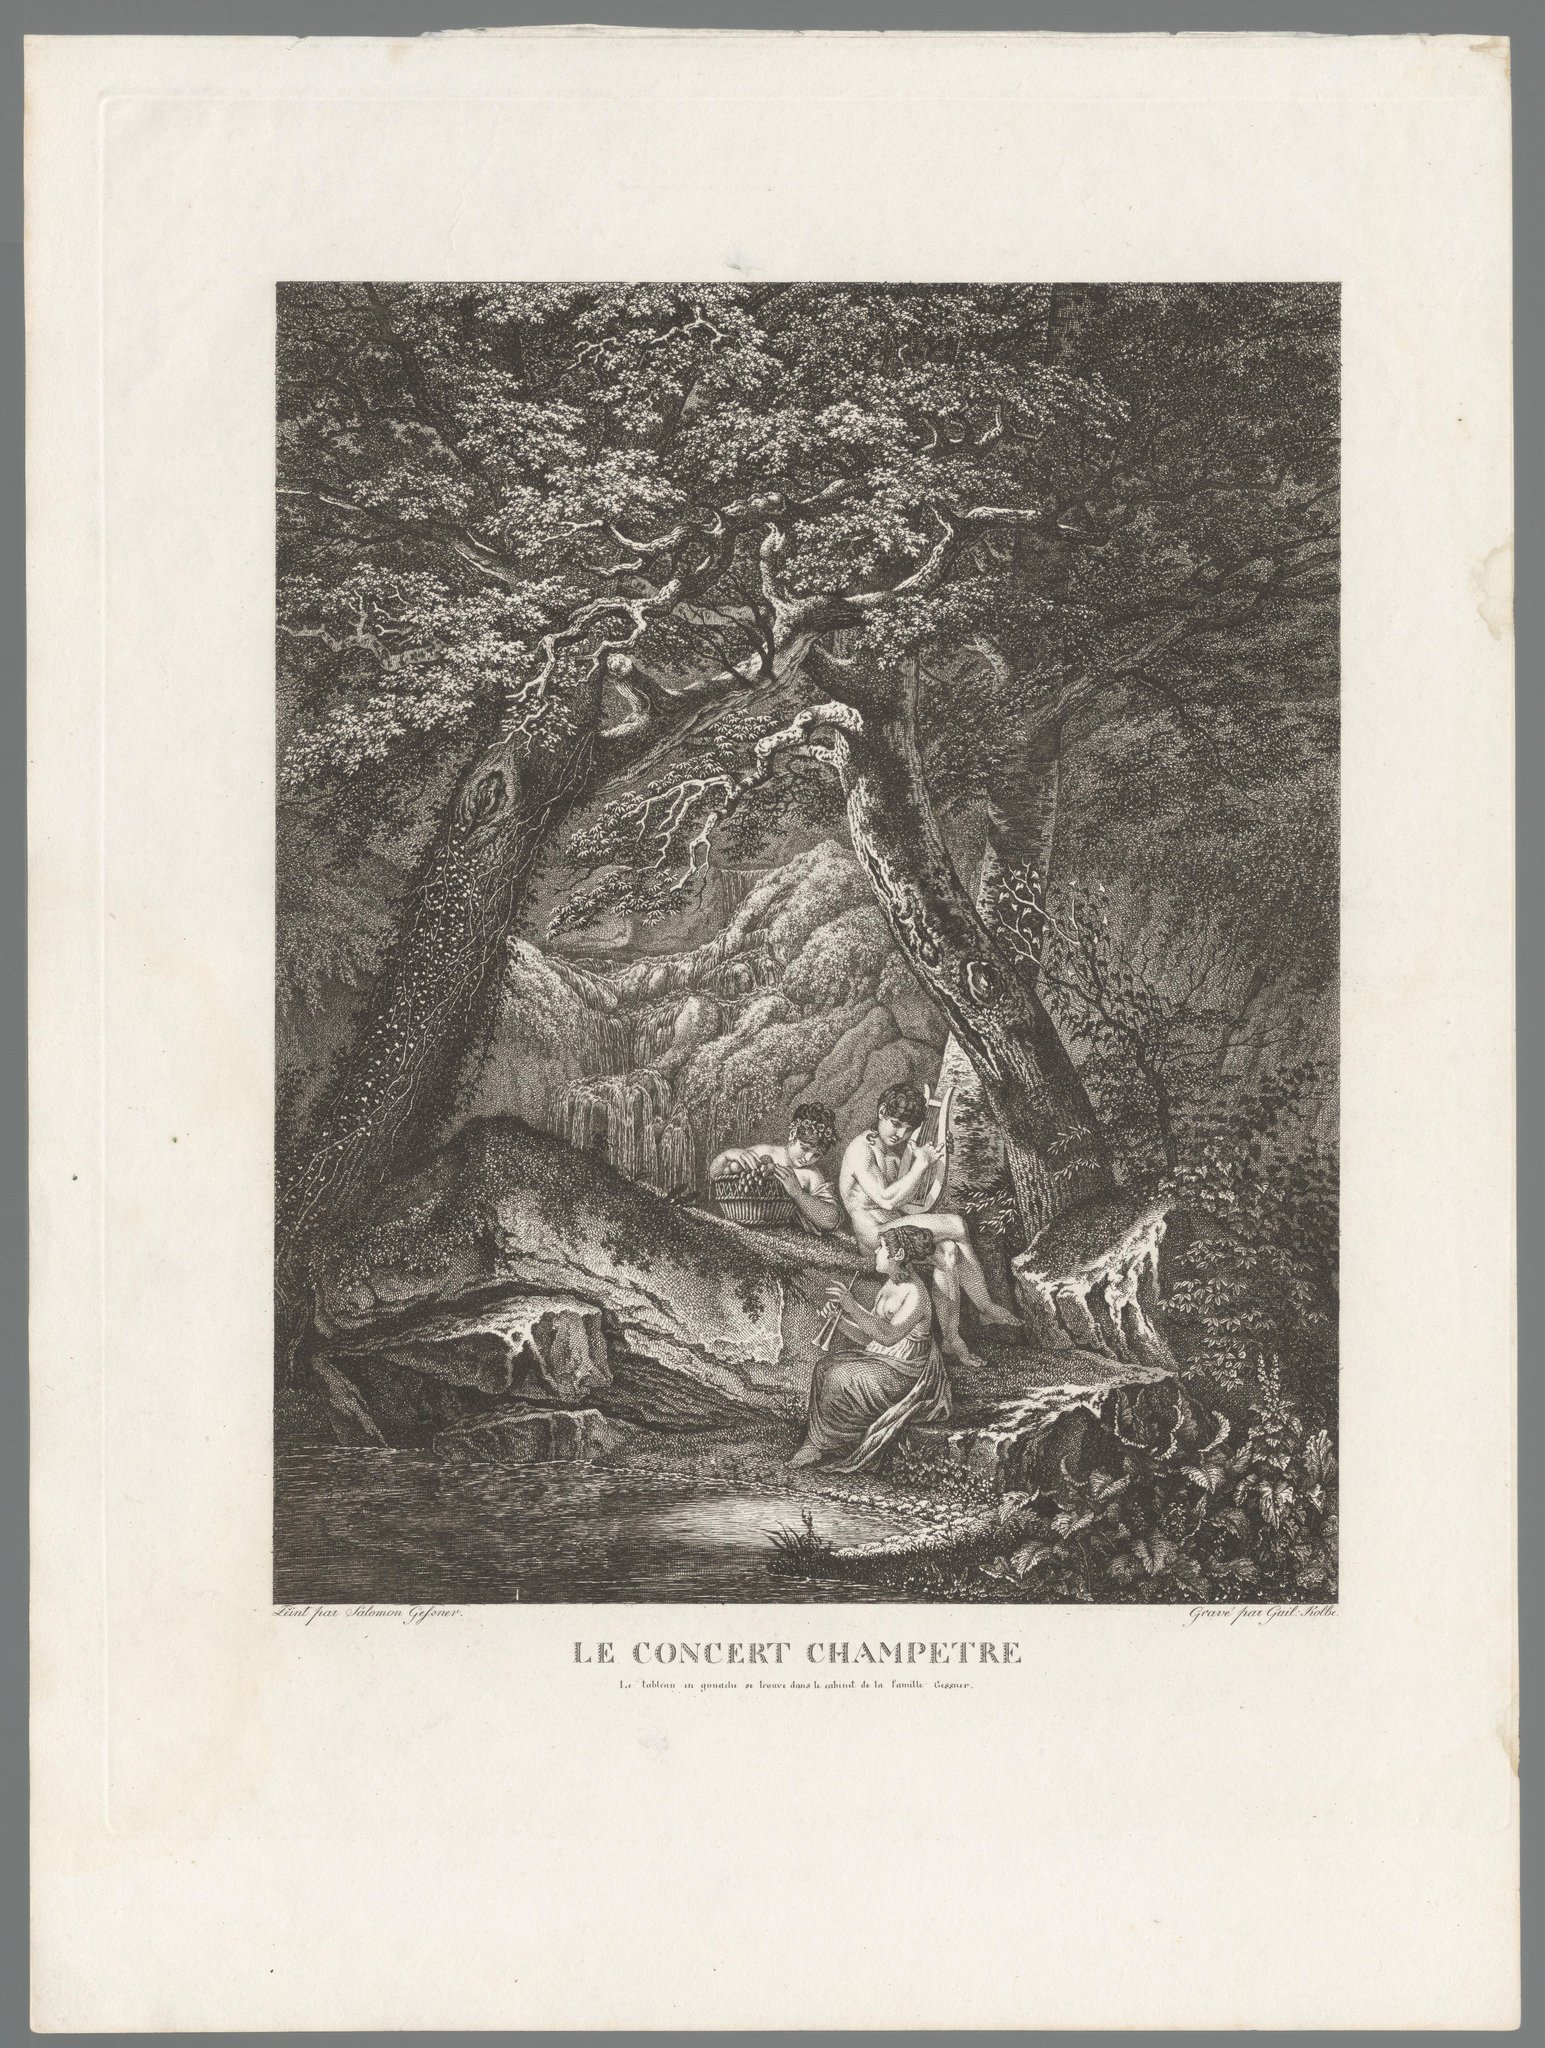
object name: print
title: Collection des tableaux en gouache et des dessins de Salomon Gessner. Gravés à l'eau forte par Guil. Kolbe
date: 1811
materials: paper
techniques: etching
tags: waterfall, nymphs (in general); 'ninfe in commune' (ripa), more than one musician with instrument - cc - 'concert champêtre', pastorals, arcadian scenes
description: Deze prent is gemaakt voor een serie uit 1811 getiteld: Collection des tableaux en gouache et des dessins de Salomon Gessner. Gravés à l'eau forte par Guil. Kolbe. De gehele serie is in het bezit van het RMA onder inv. nr. RP-P-2005-184.